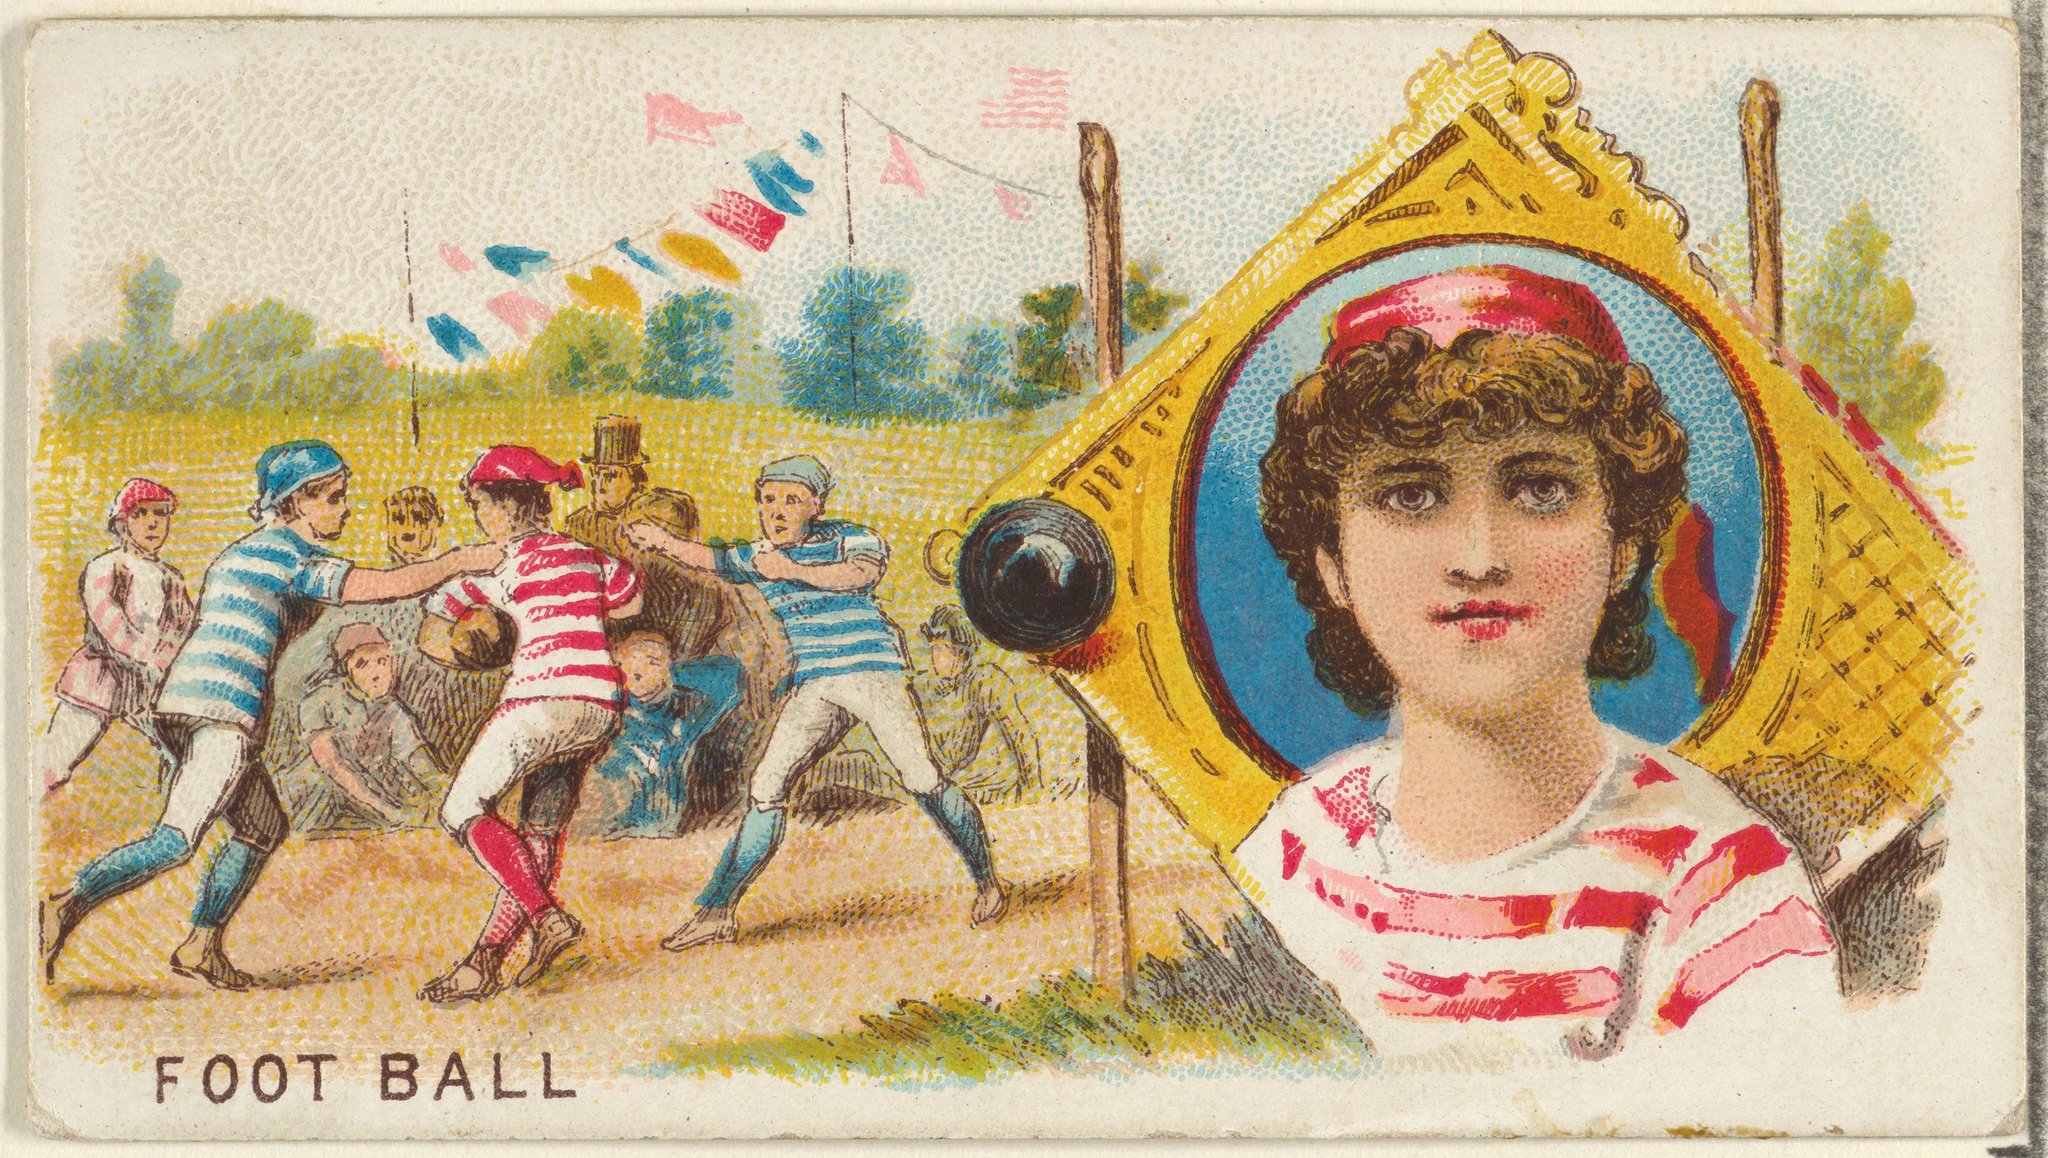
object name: print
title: Football, from the Games and Sports series (N165) for Old Judge Cigarettes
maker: goodwin & company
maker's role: publisher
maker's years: 1850-1950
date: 1889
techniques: color lithograph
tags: football,athletes